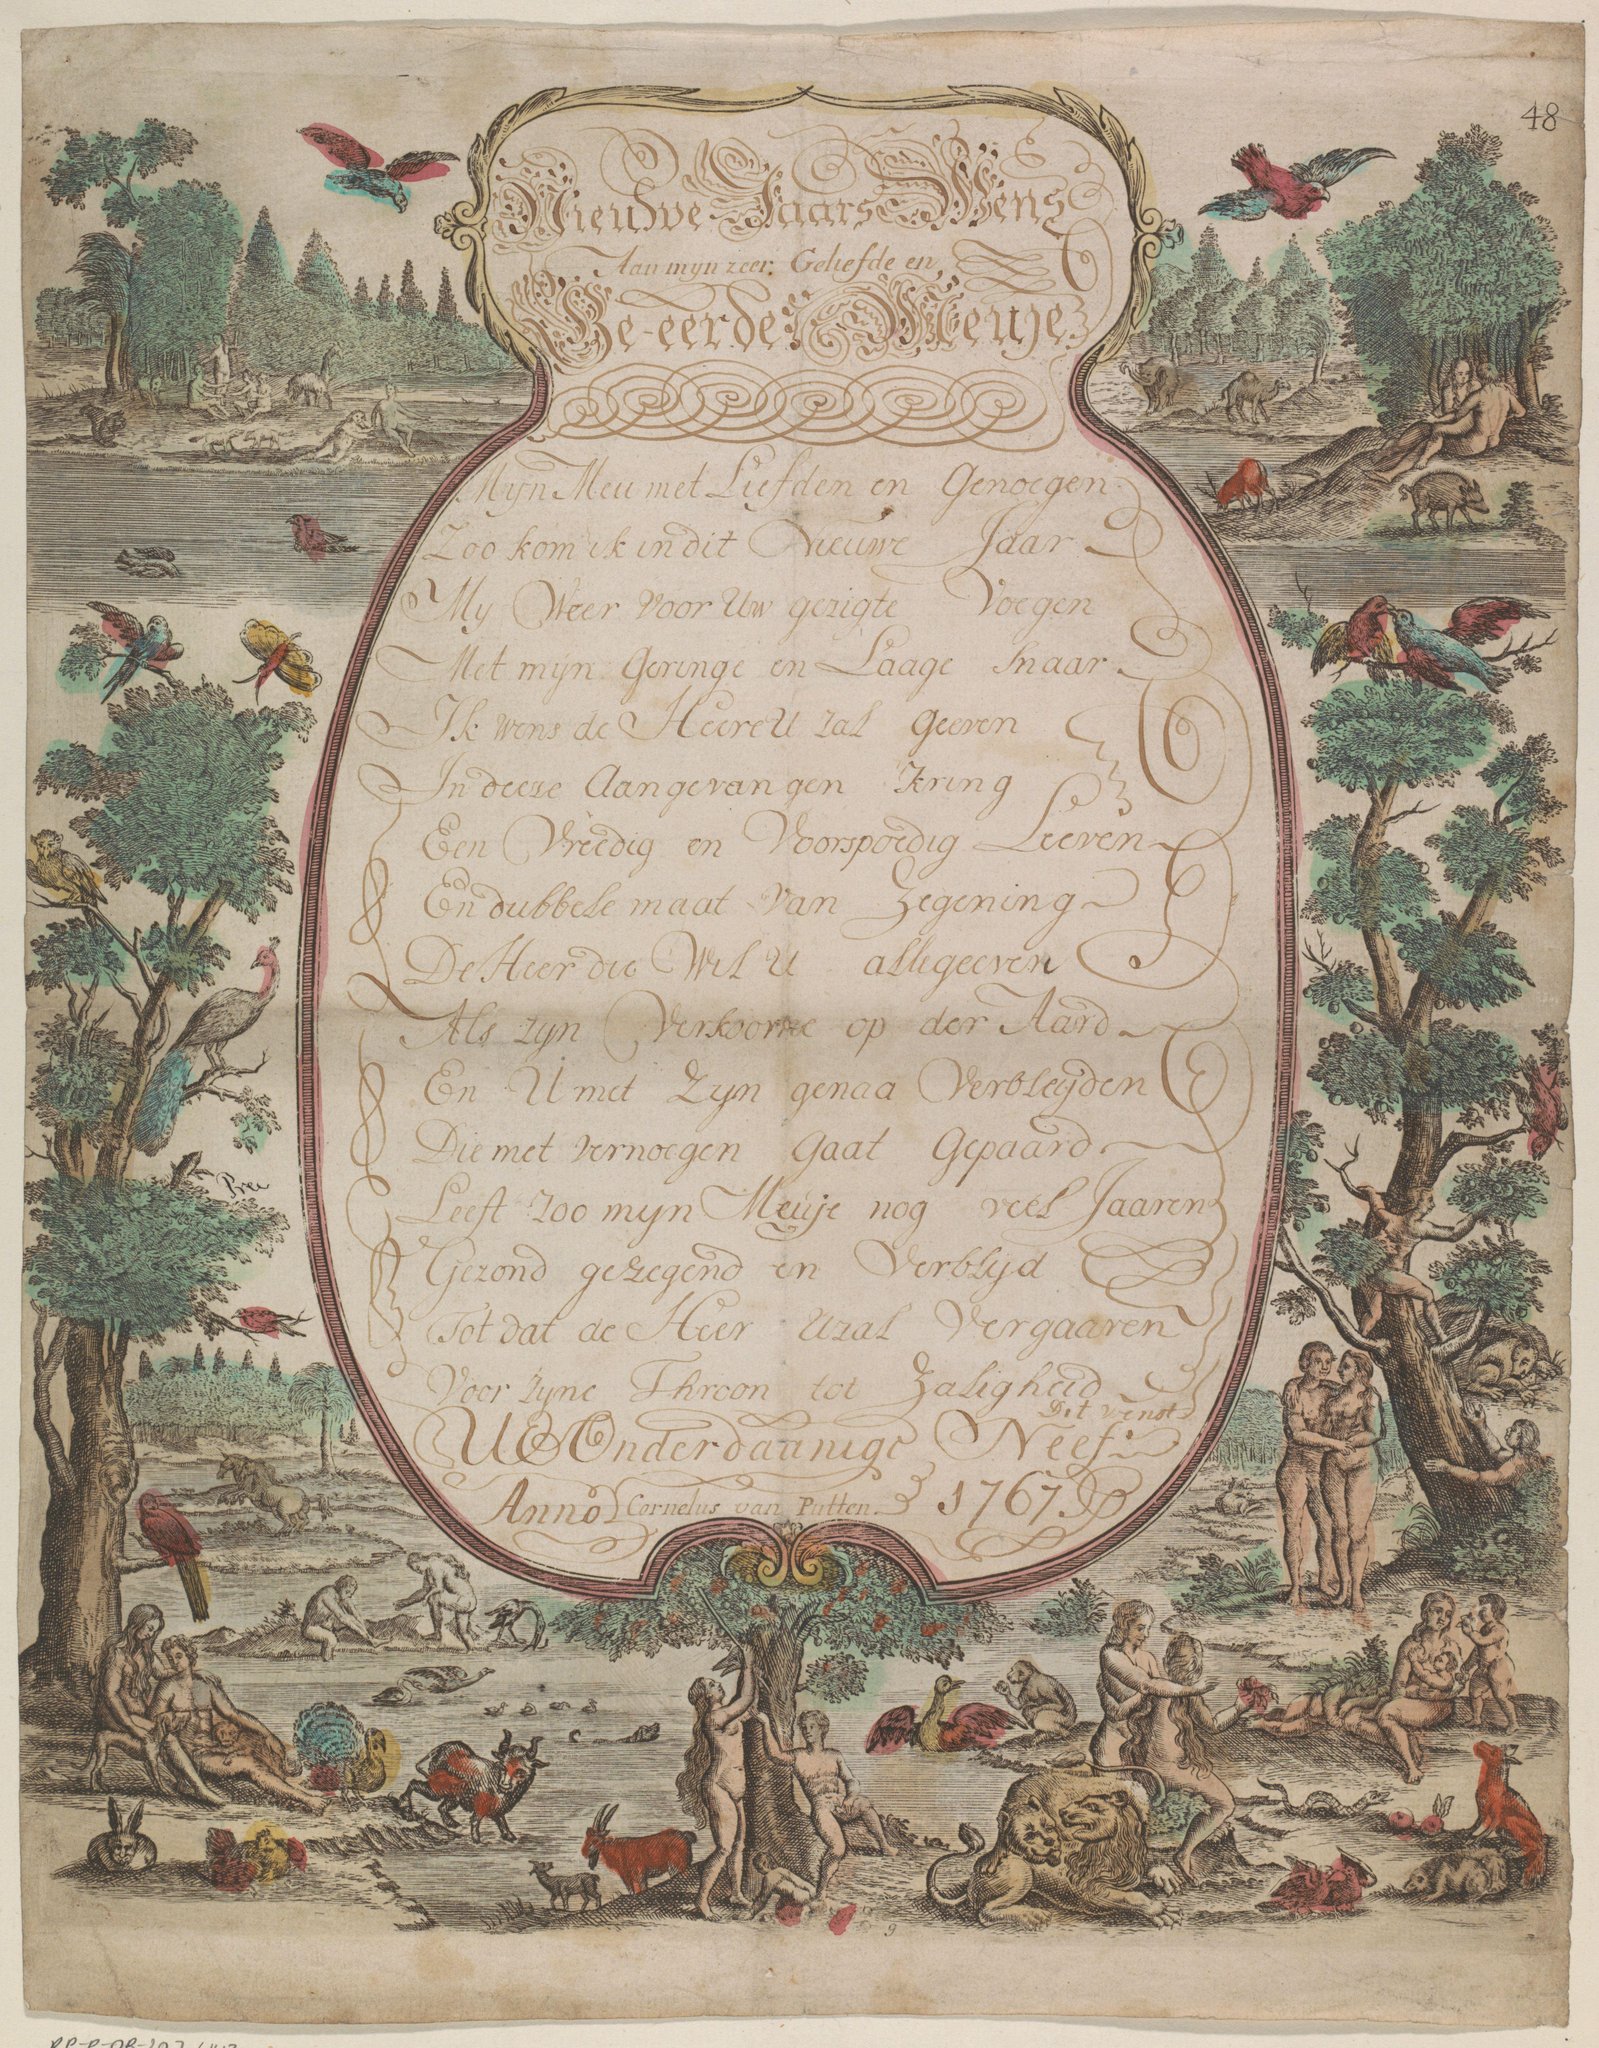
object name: wensbrief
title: Wensbrief met Adam en Eva in het paradijs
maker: Anonymous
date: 1767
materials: ink, paper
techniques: calligraphy, colour, etching, pen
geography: netherlands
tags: adam and eve in paradise (before the fall)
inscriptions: inscription: ‘Nieuwe jaars wens / aan mijn zeer: geliefde en, Ge-eerde Meuje / Mijn Meu met liefden en genoegen ...’, collector's mark: Lugt 2760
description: Wensbrief met beschreven cartouche binnen een decoratief kader met voorstellingen van Adam en Eva in het paradijs. Handgeschreven bericht in kalligrafie (Nieuwjaarswens) door Cornelis van Putten aan zijn meu. Genummerd rechtsboven: 48. Genummerd middenonder: 9.